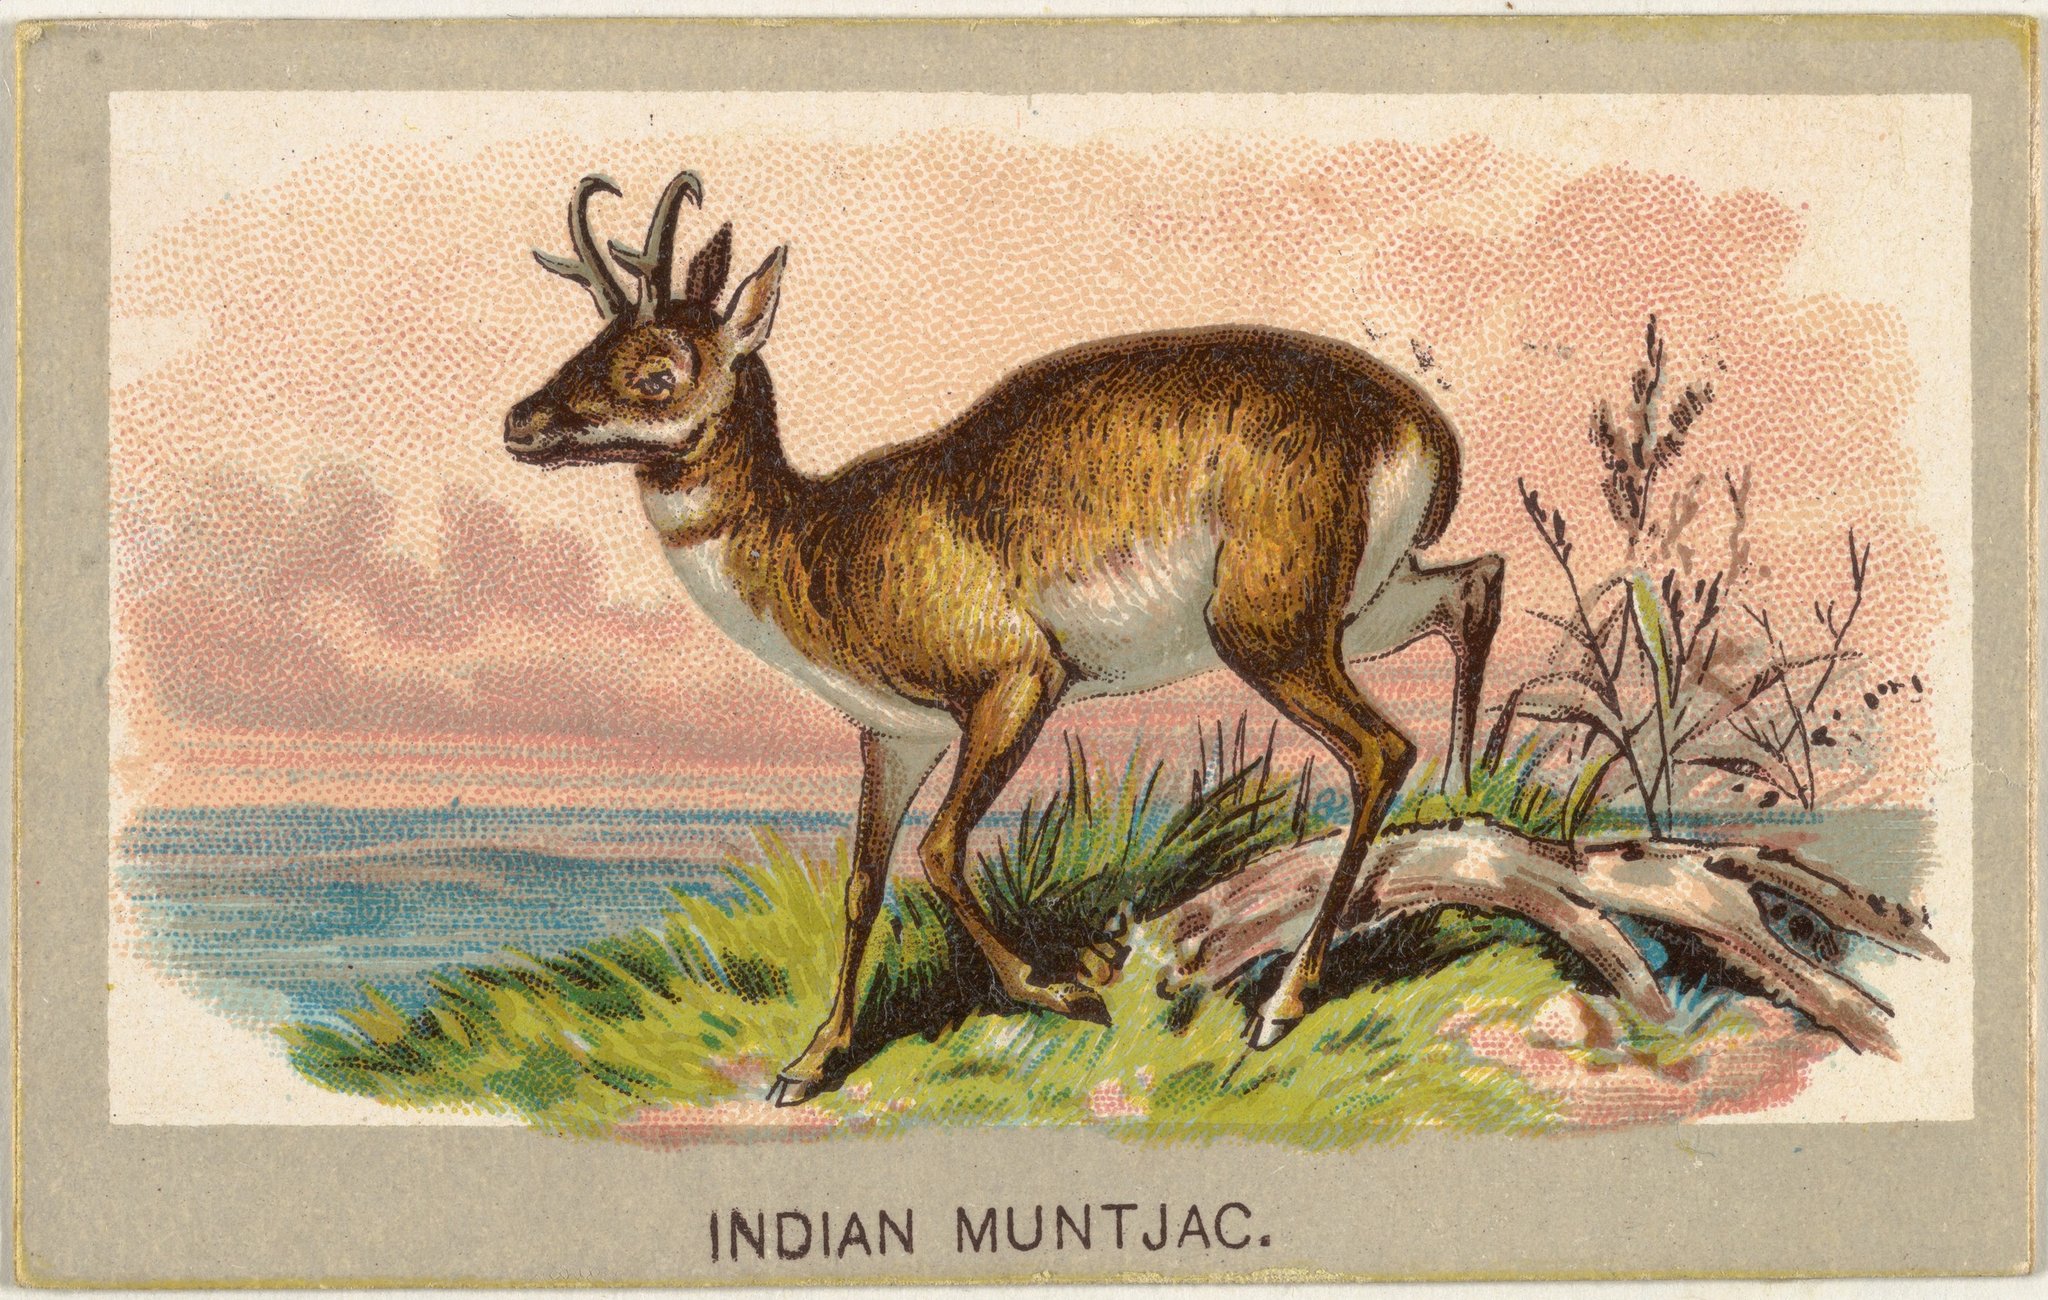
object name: print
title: Indian Muntjac, from the Animals of the World series (T180), issued by Abdul Cigarettes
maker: abdul cigarettes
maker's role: publisher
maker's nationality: american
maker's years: 1881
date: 1881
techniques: color lithograph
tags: animals